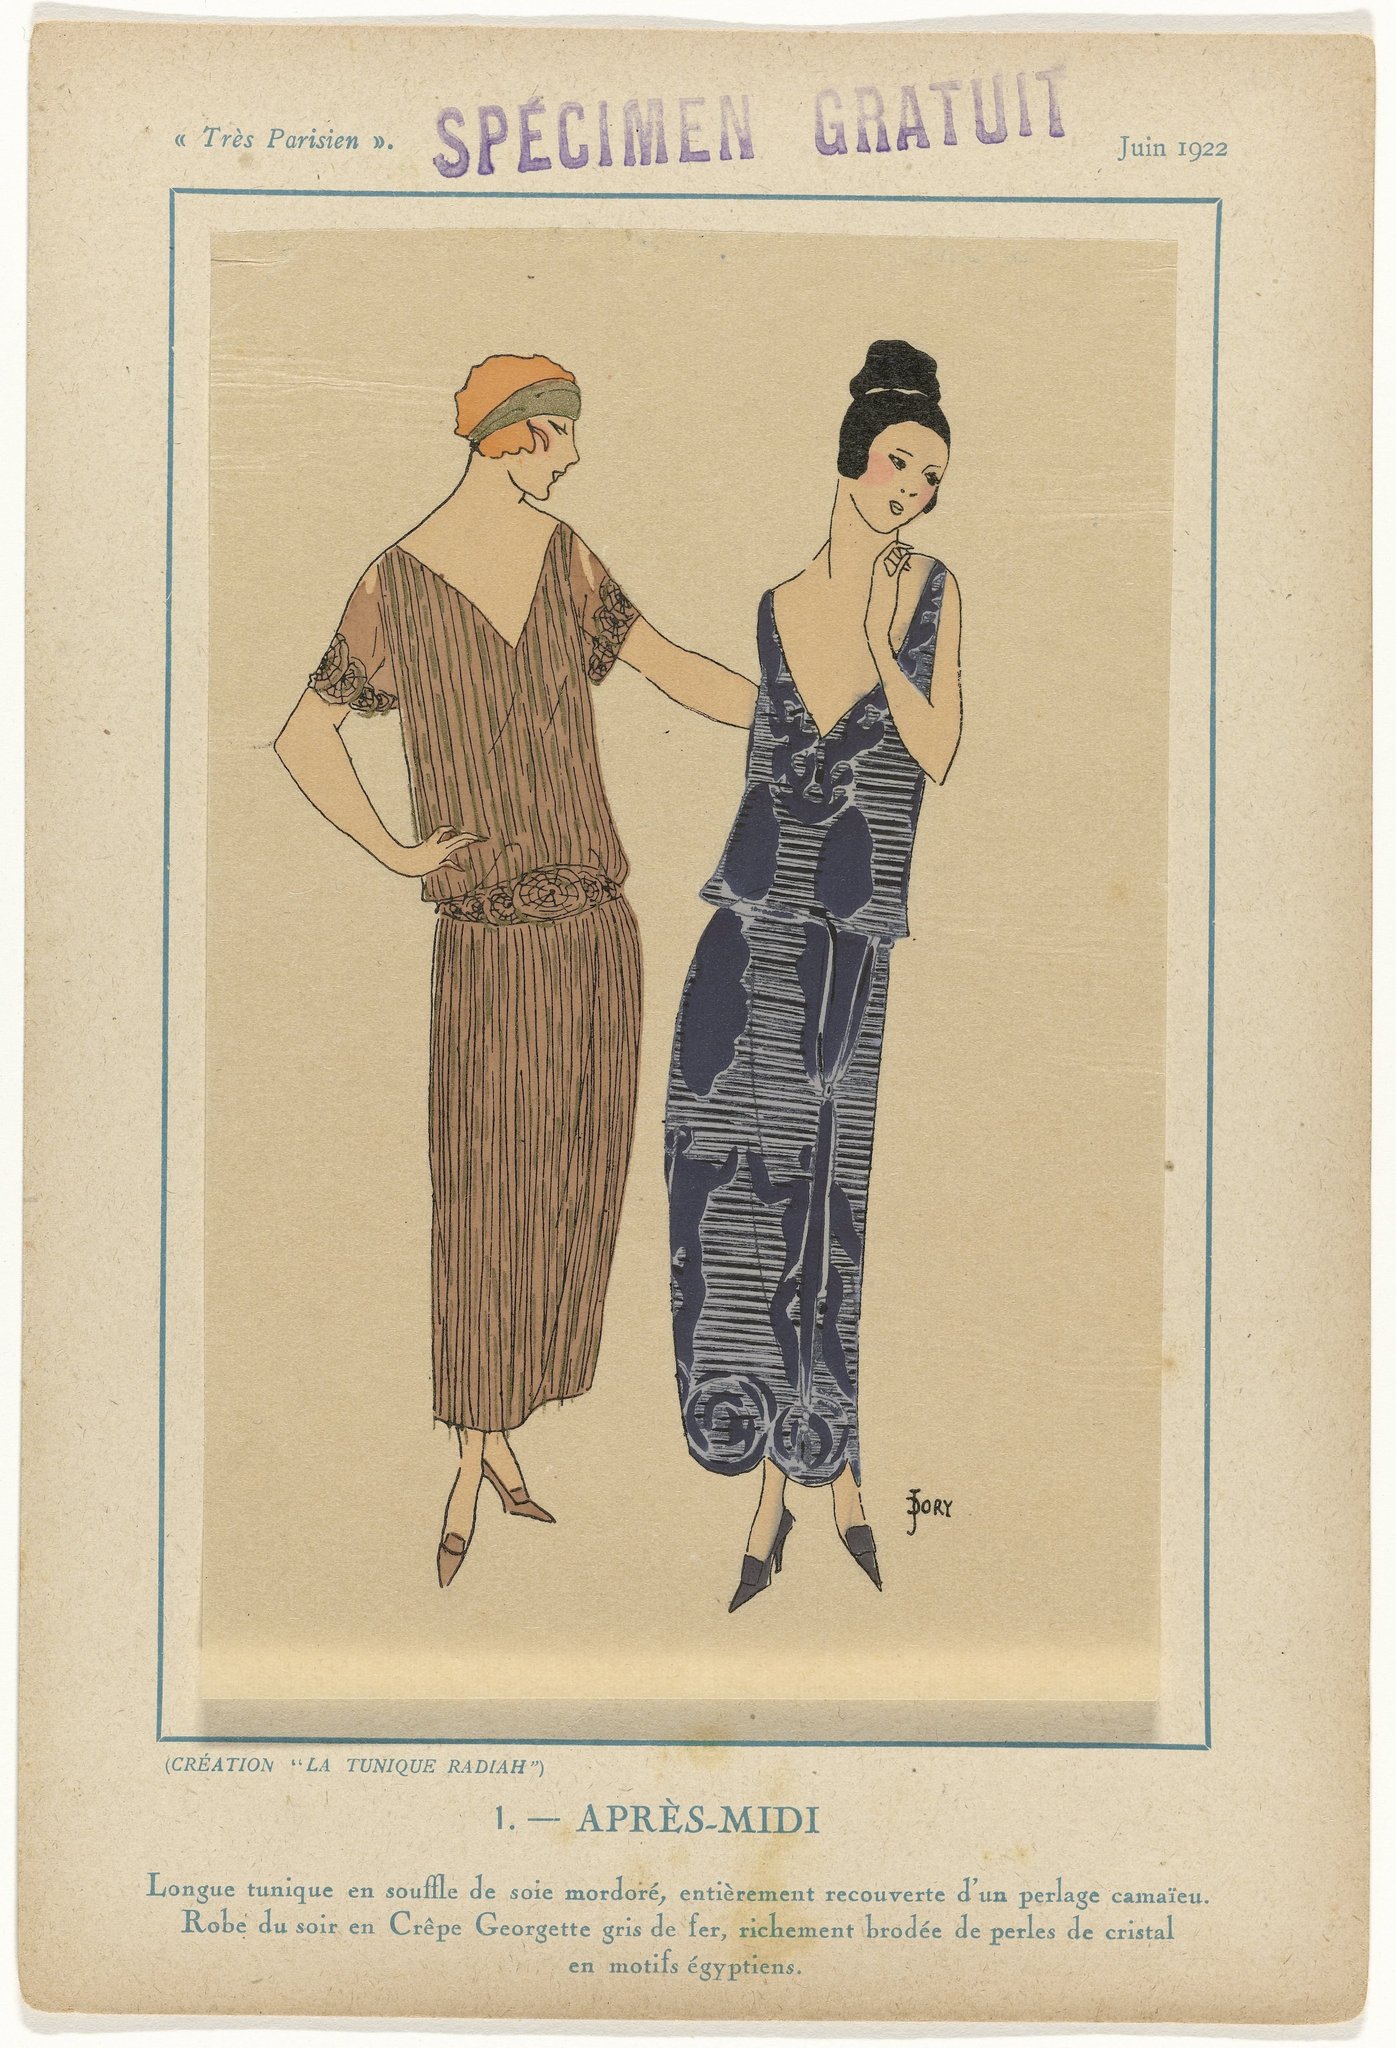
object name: fashion print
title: Très Parisien, juin 1922: 1 (Spécimen gratuit) - APRÈS-MIDI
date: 1922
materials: paper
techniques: brush, hand coloring, letterpress printing, lithography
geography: paris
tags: diadem, tiara (+ women's clothes), dress, gown: evening dress (+ women's clothes), embroidery (ornamentation) (+ women's clothes), dress, gown (tunic) (+ women's clothes), fashion plates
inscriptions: inscription: ‘(CRÉATION "LA TUNIQUE RADIAH")’, stamp: ‘SPÉCIMEN GRATUIT’, caption: ‘1. - APRÈS-MIDI / Longue tunique en souffle de soie mordoré, entièrement recouverte d'un perlage camaïeu. Robe du soir en Crêpe Georgette gris de fer, richement brodée de perles de cristal en motifs égyptiens.’, title: ‘Très Parisien / Juin 1922’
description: Creaties van "La Tunique Radiah": Lange tuniek van zijde; avondjapon van grijze crêpe Georgette, geborduurd met Egyptische motieven. Prent uit het modetijdschrift Très Parisien (1920-1936).